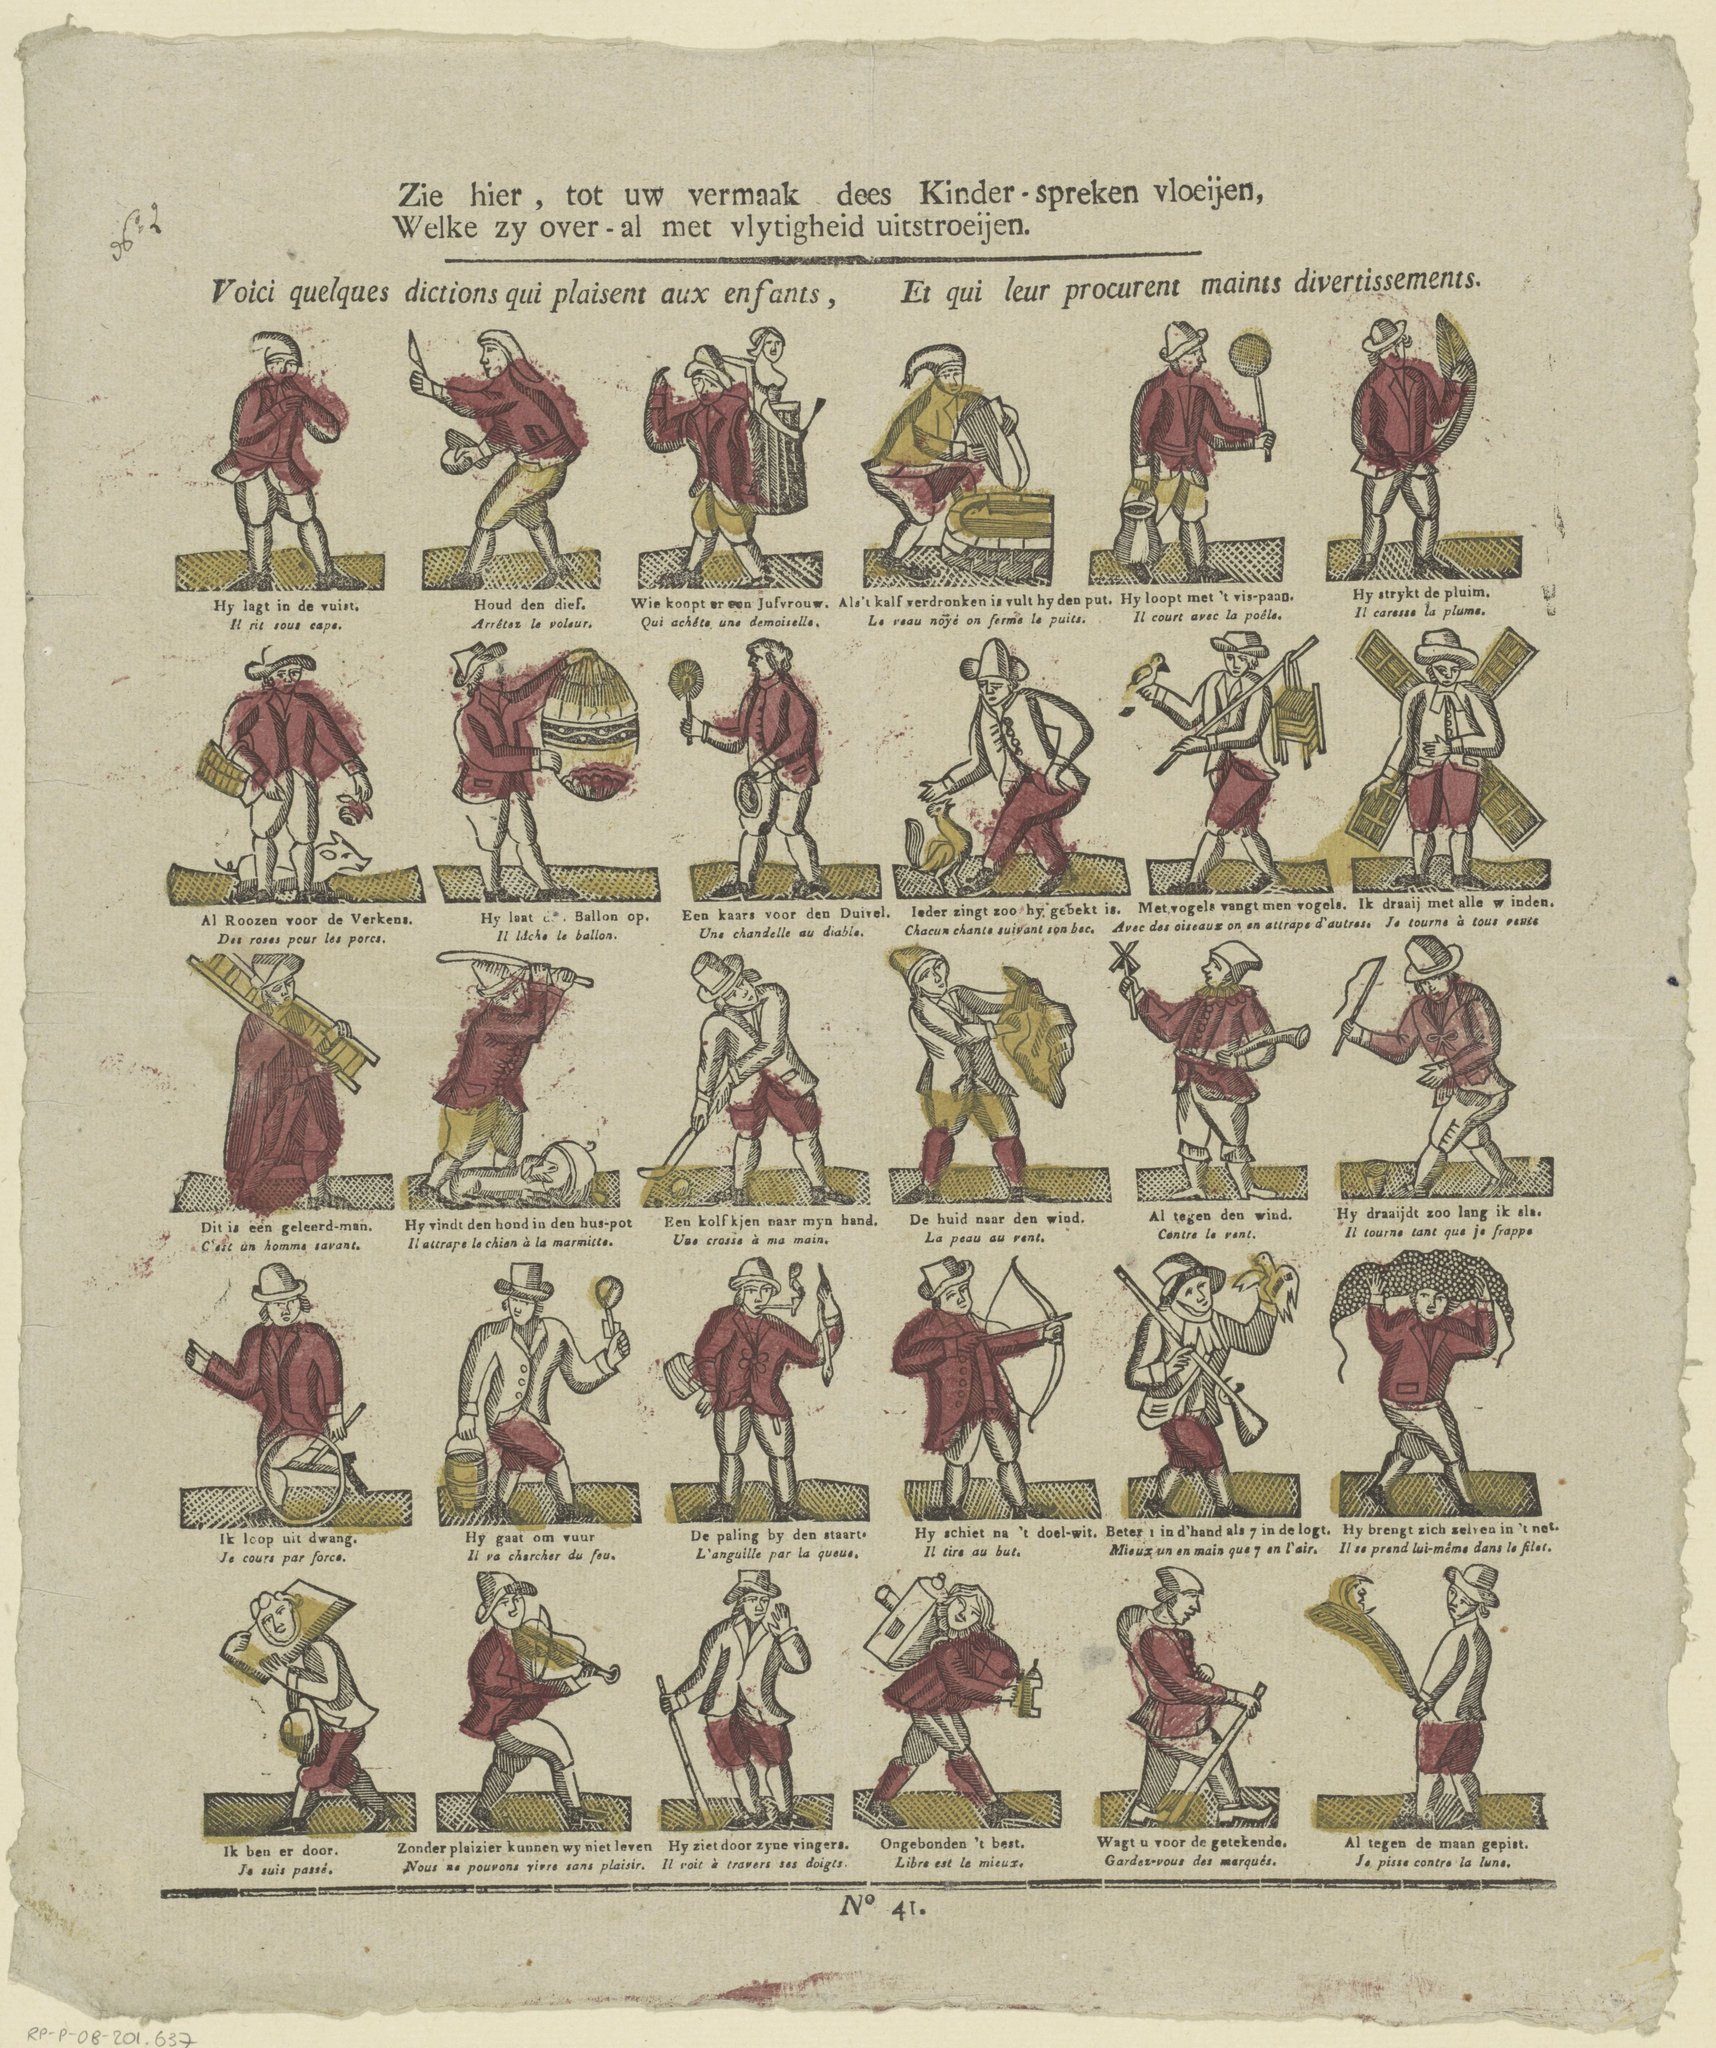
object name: popular print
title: Zie hier, tot uw vermaak dees kinder-spreken vloeijen, / Welk zy over-al met vlytigheid uitstroeijen / Voici quelques dictions qui plaisent aux enfants, / Et qui leur procurent maints divertissements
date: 1800-1833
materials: paper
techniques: colour, letterpress printing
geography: turnhout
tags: proverbs, sayings, etc.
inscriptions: collector's mark: Lugt 2760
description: Blad met 30 verbeeldingen van spreekwoorden en gezegden. Onder elke voorstelling een onderschrift in het Nederlands en in het Frans. Genummerd midden onder: No 41.